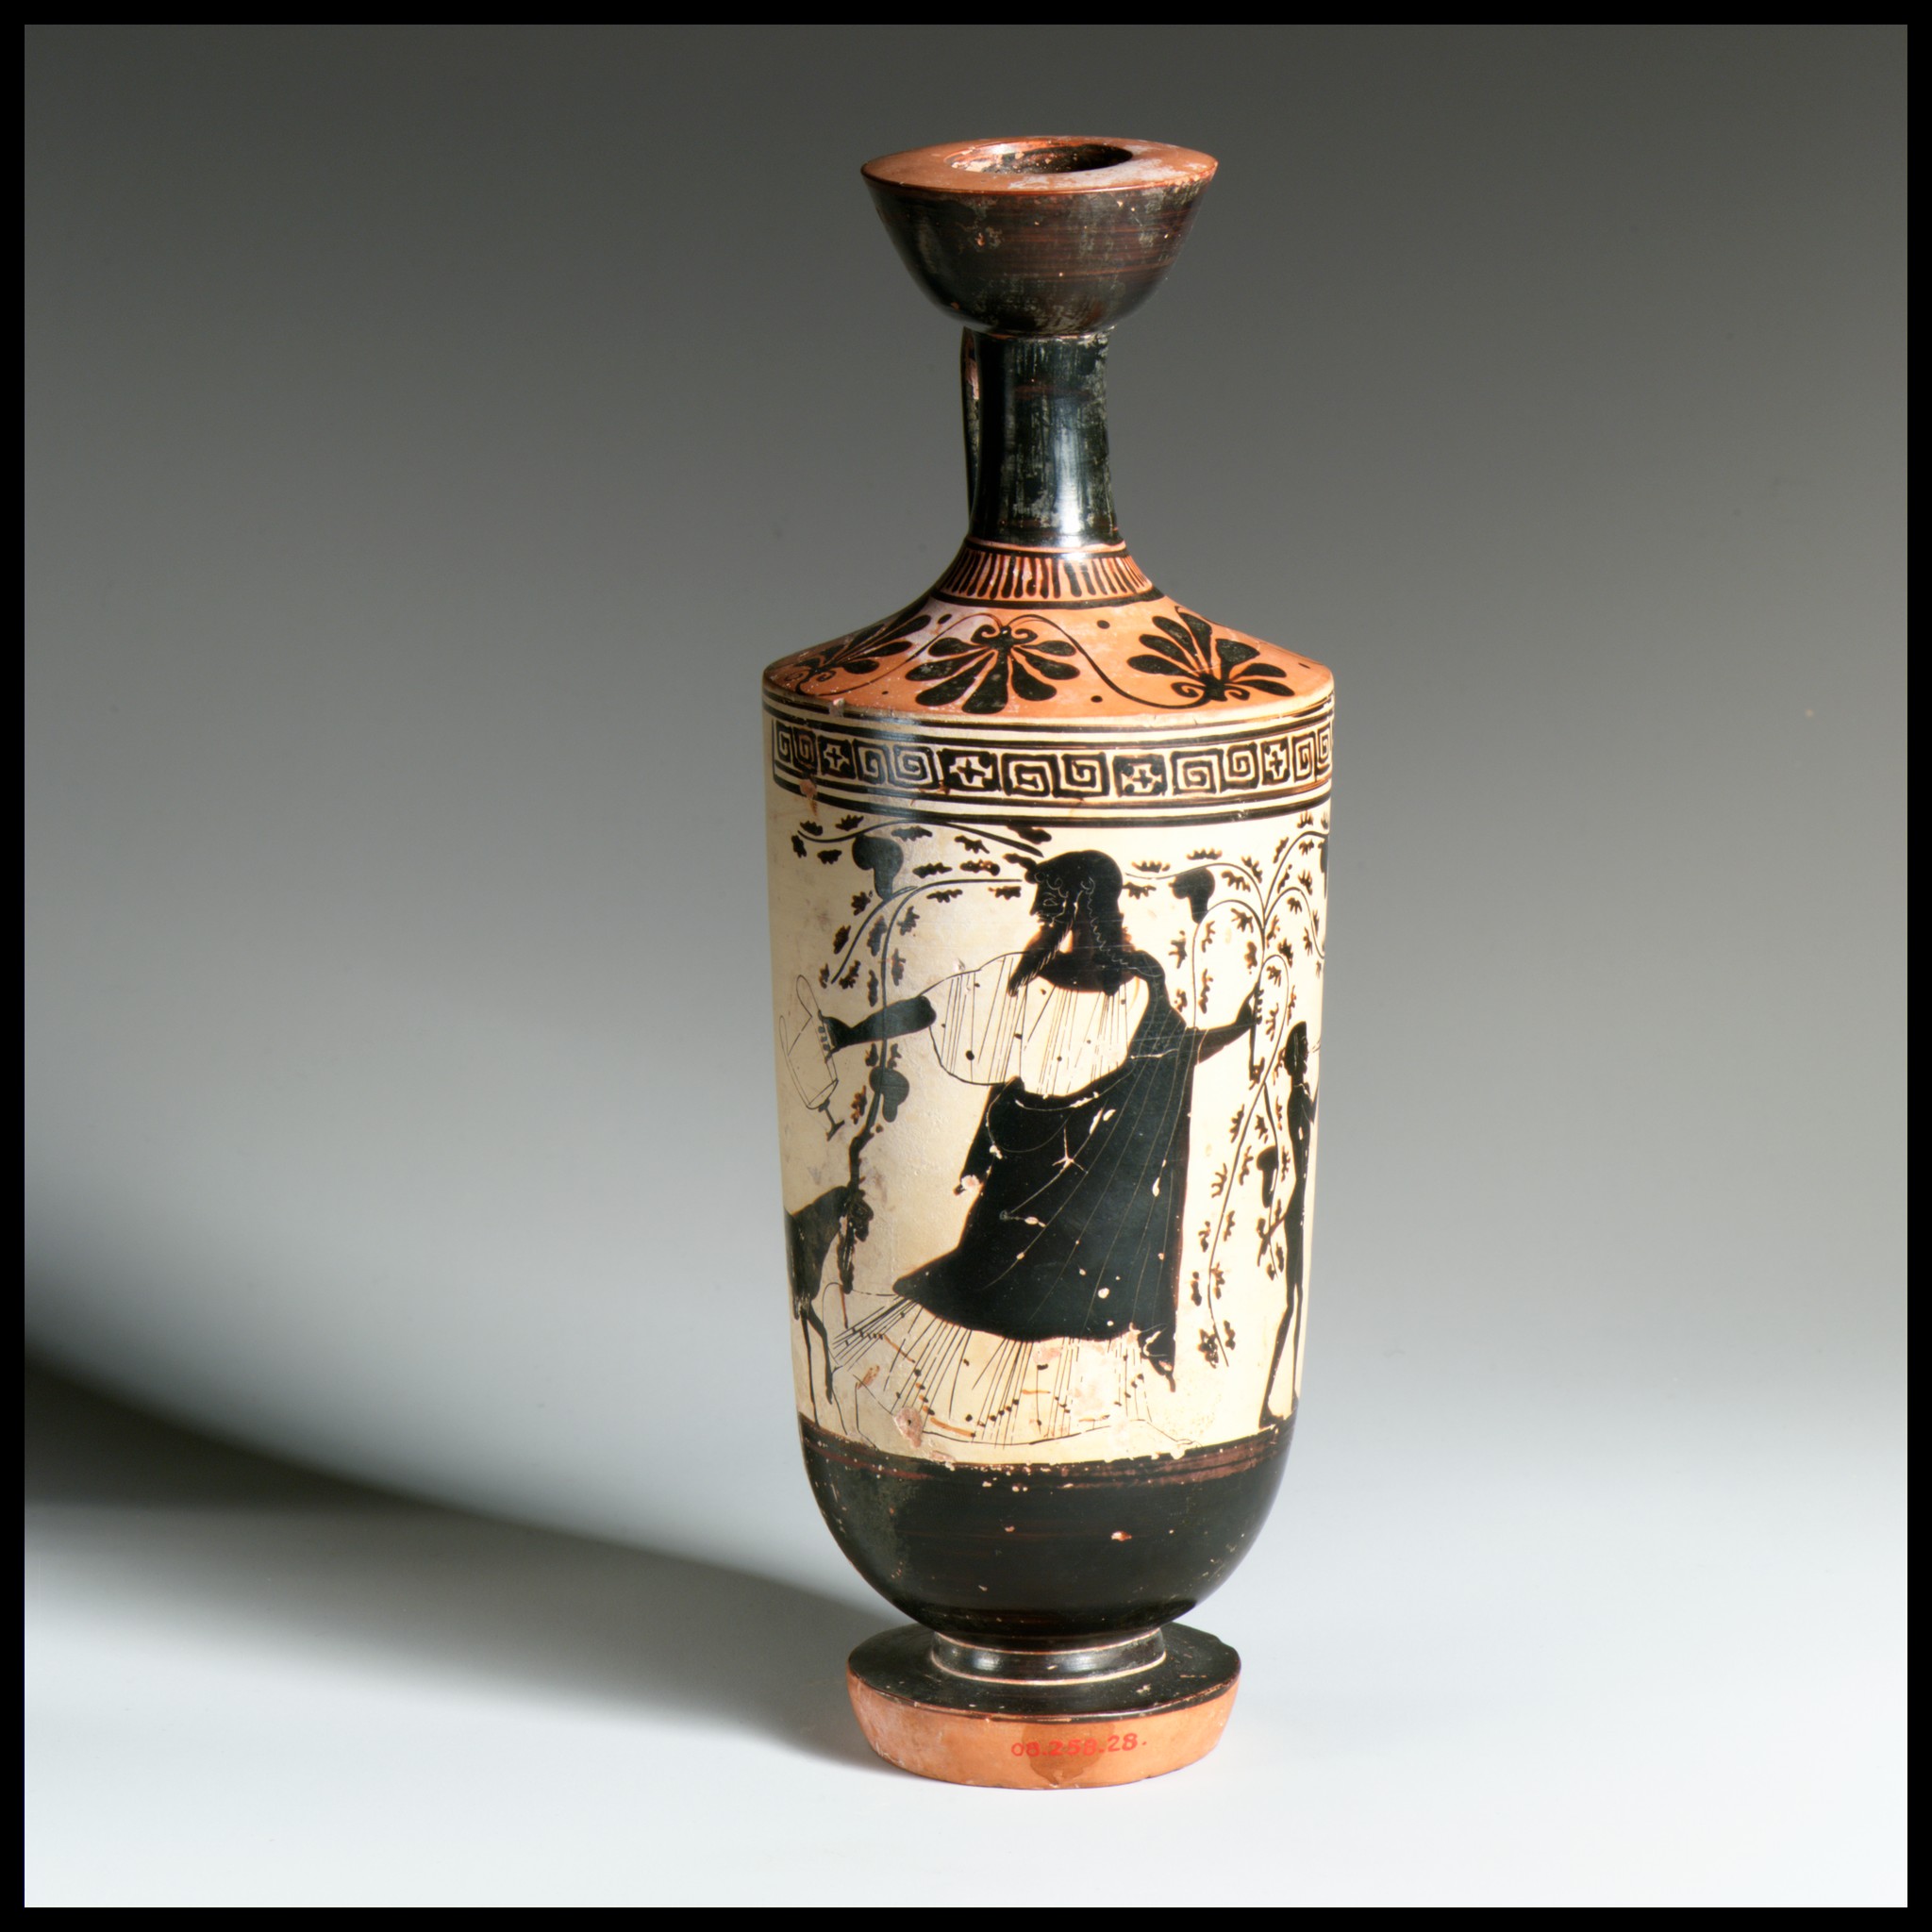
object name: lekythos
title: Terracotta lekythos (oil flask)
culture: greek, attic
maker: bowdoin painter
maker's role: artist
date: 480 BCE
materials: terracotta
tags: dionysus,satyrs,goats